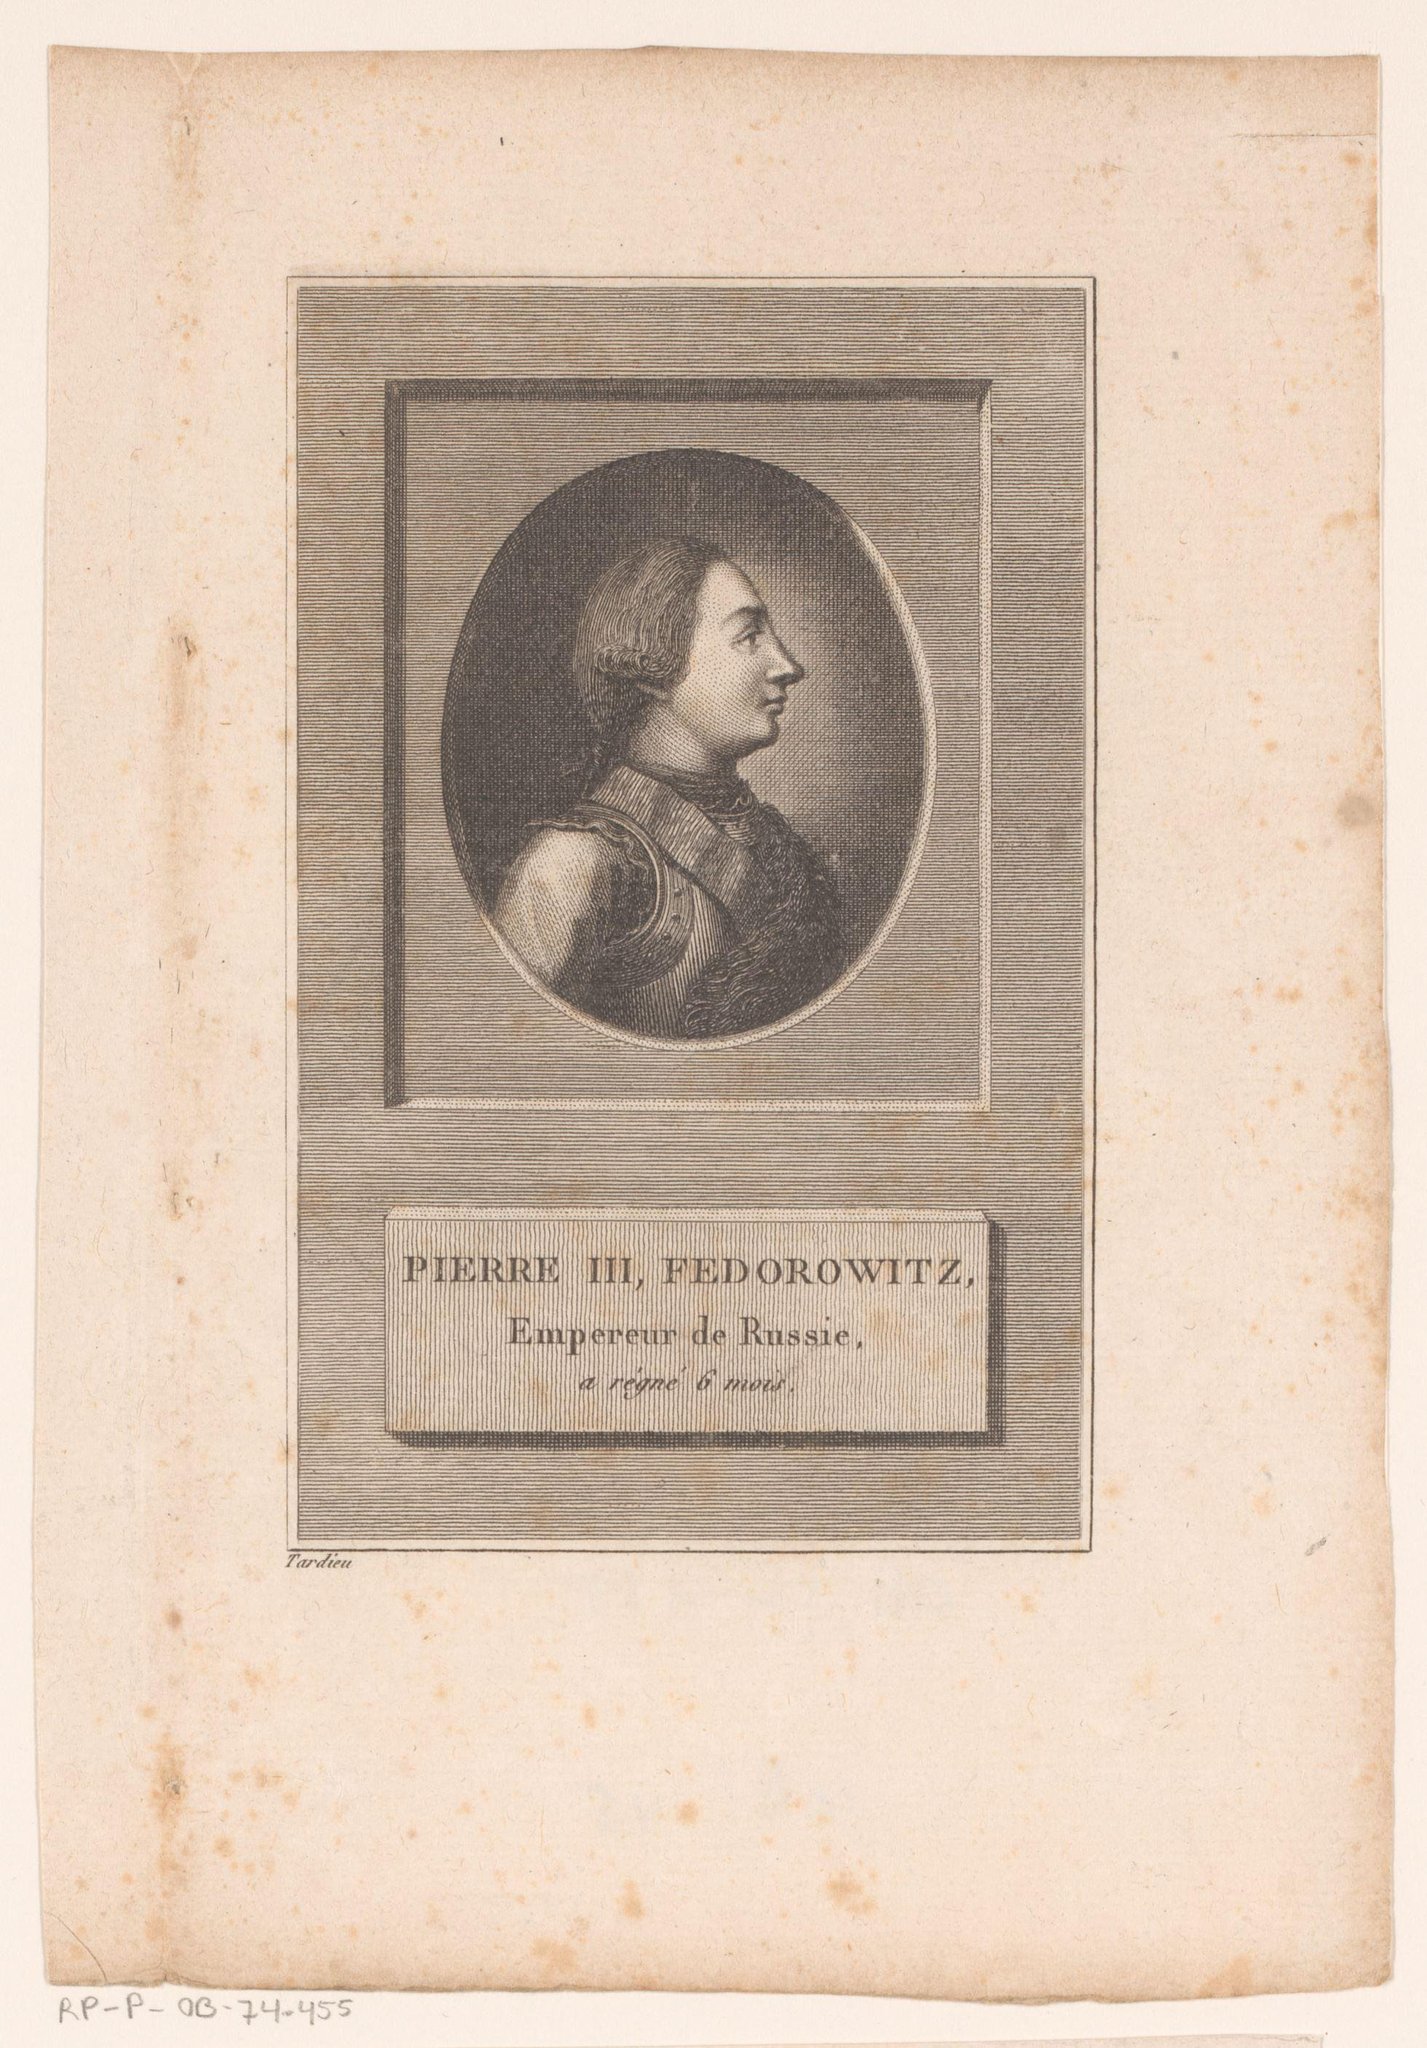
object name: print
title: Portret van tsaar Peter III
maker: alexandre tardieu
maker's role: print maker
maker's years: 1756-1844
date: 1766-1844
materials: paper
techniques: engraving, etching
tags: historical persons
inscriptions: collector's mark: Lugt 2228